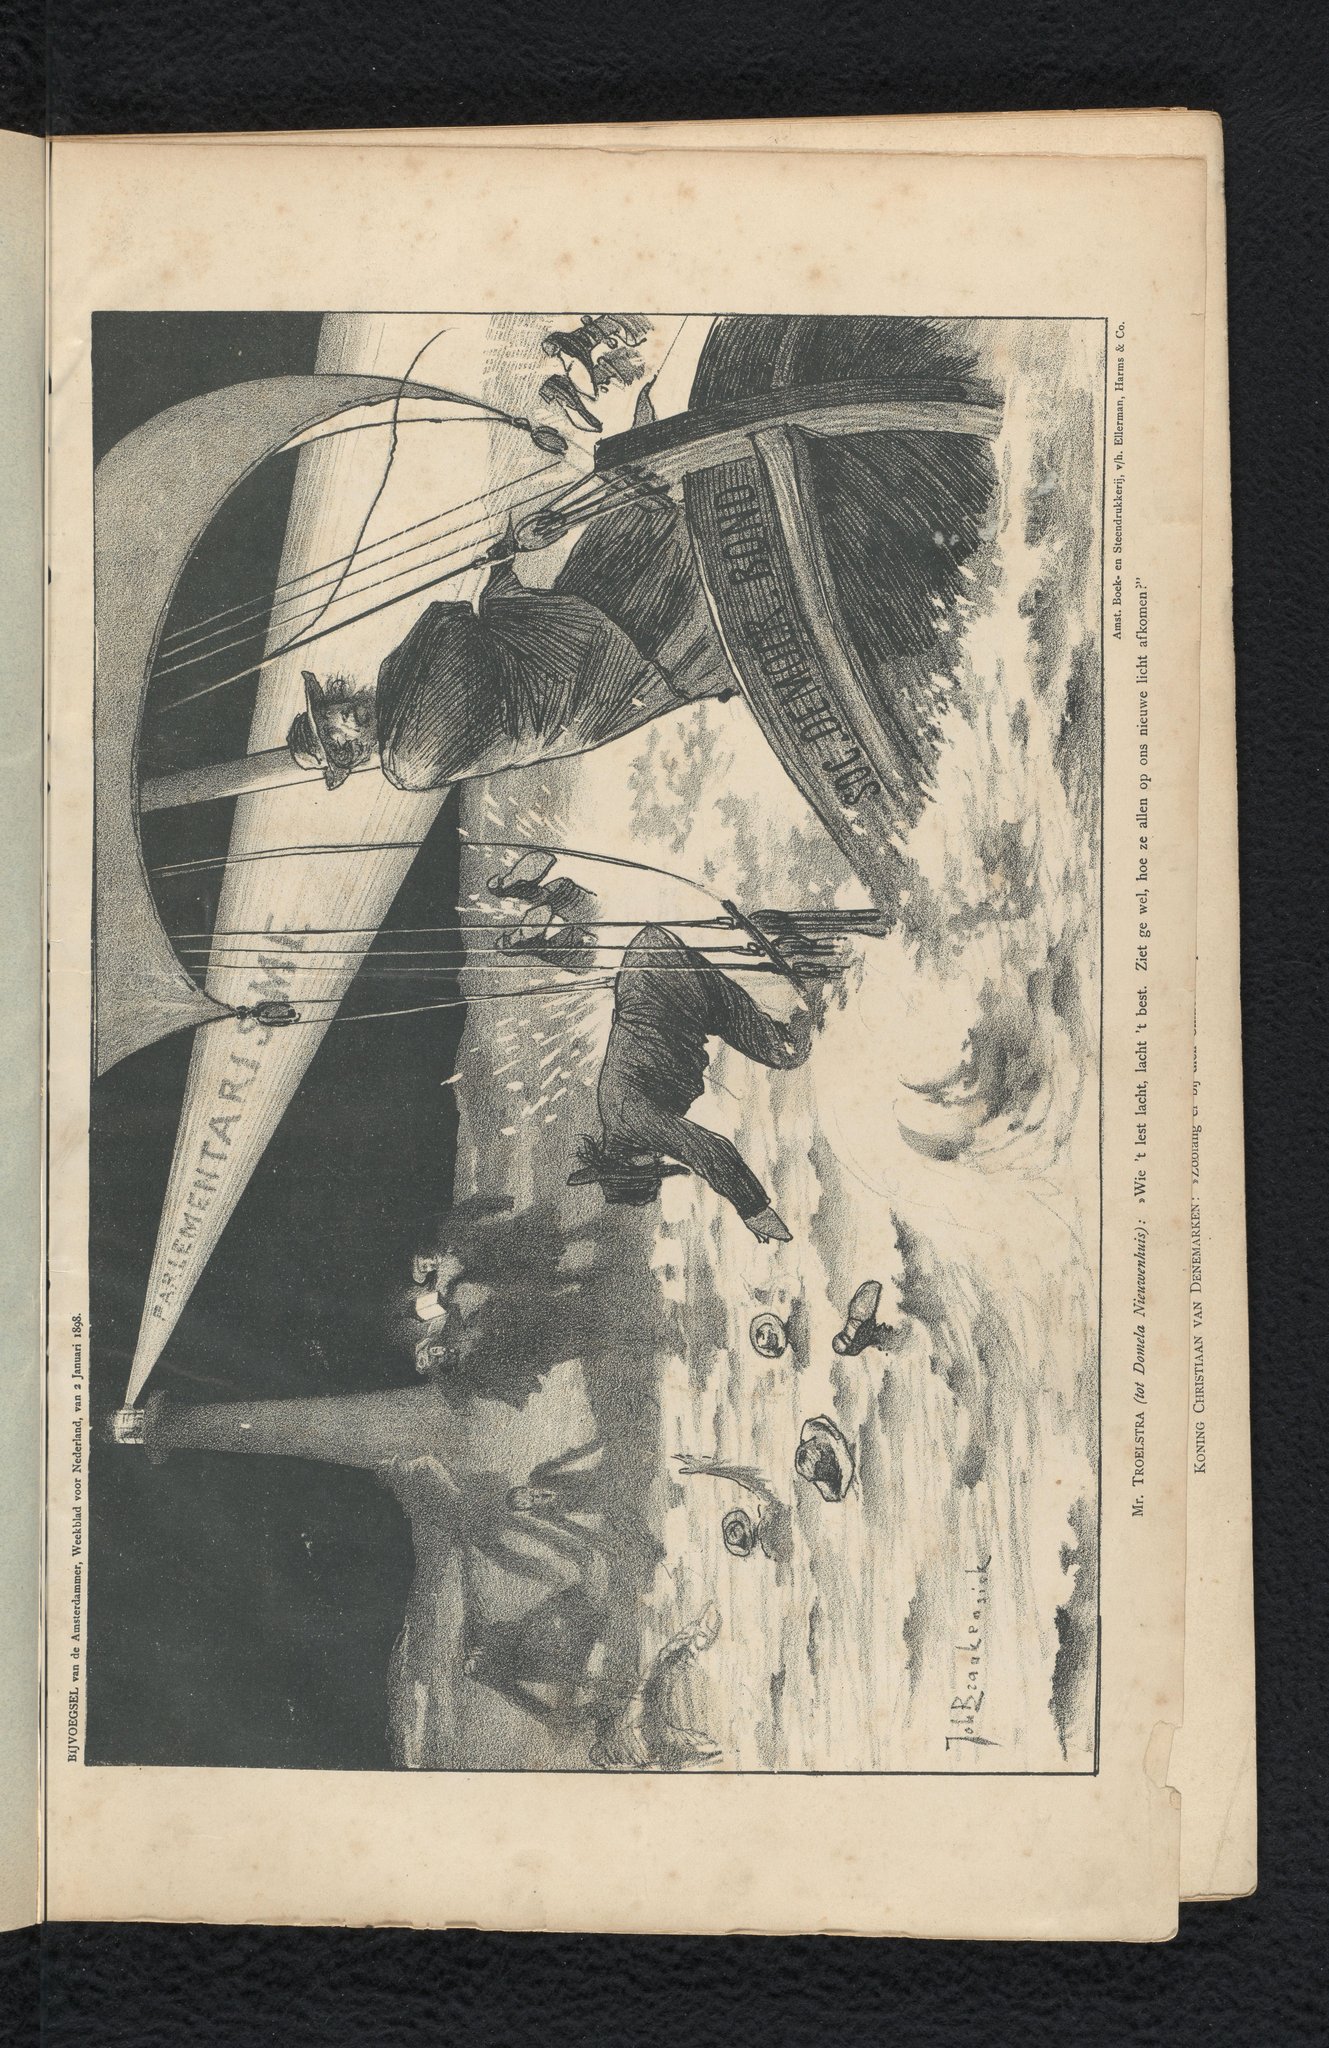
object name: cartoon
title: De aftreding van den Hoofdredacteur van "Recht voor Allen"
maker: johan braakensiek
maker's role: draughtsman, print maker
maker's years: 1858-1940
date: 1898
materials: paper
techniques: lithograph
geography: amsterdam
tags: politician, ferdinand domela nieuwenhuis, lighthouse, lightship, shipwreck, political caricatures and satires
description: Troelstra ziet hoe de kapitein met het schip van de Sociaal-Democratische Bond ten onder gaat. Naar aanleiding van het aftreden van Domela Nieuwenhuis als hoofdredacteur van het sociaaldemocratisch tijdschrift 'Recht voor Allen'. Aan de kust schijnt de vuurtoren het licht van het parlementarisme.